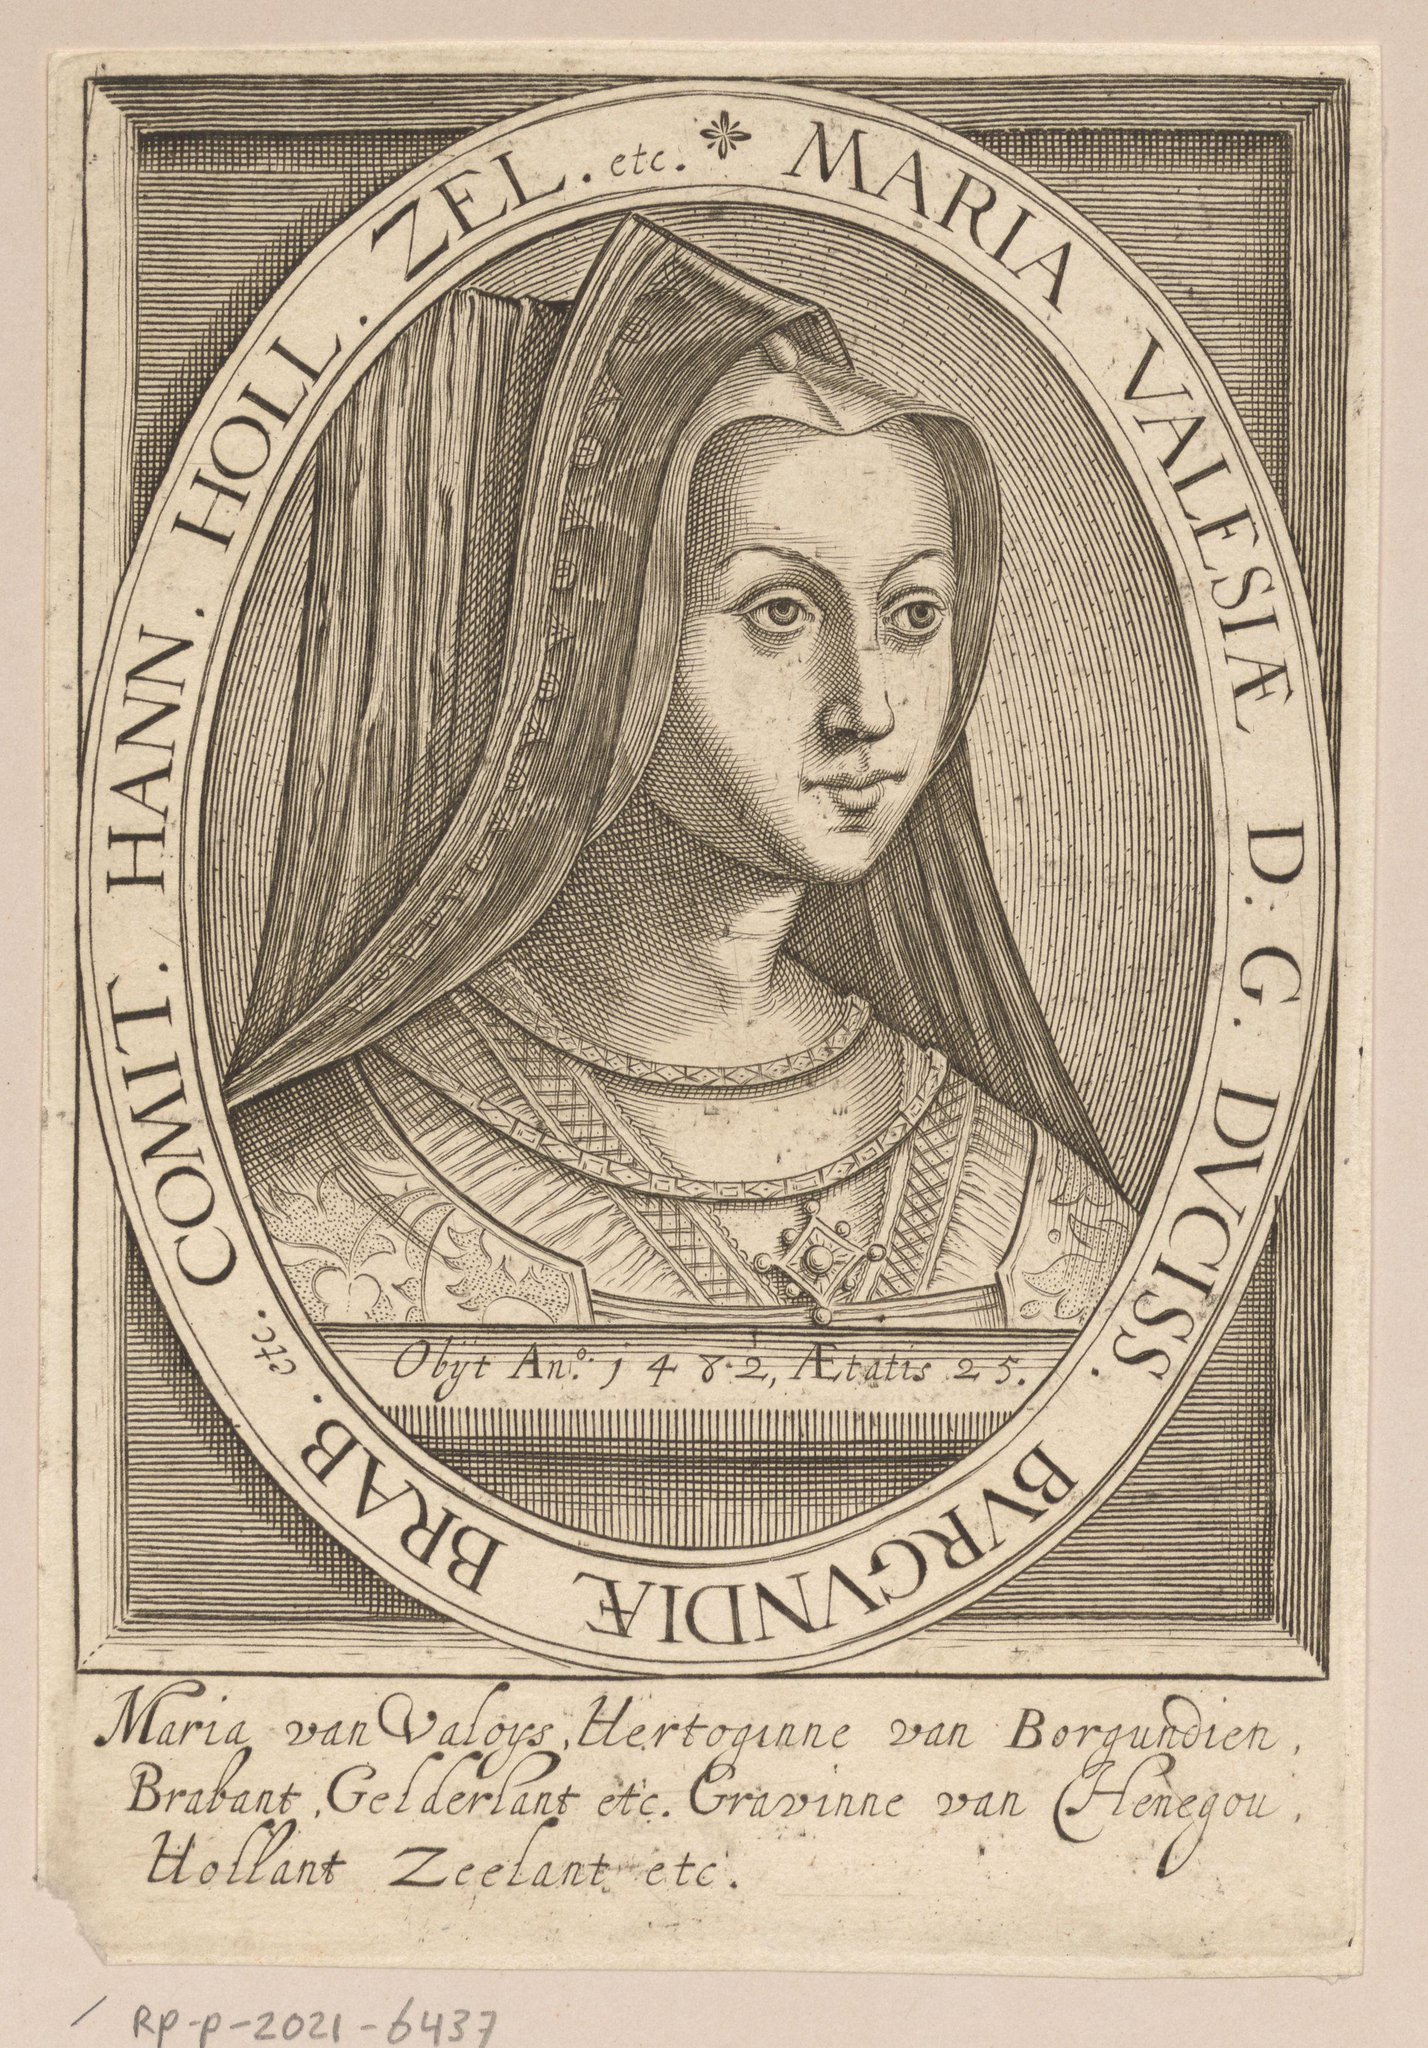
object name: print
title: Portret van Maria van Bourgondië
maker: Anonymous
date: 1614-1617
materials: paper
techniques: engraving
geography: northern netherlands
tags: brussels, bruges, maria (hertogin van bourgondië), historical persons - bb - woman, ornament ~ medallion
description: Prent met tekst in boekdruk op verso gebruikt in: Meteren, Emanuel van. Historie der Neder-landscher ende haerder na-buren oorlogen (...). Den Haag: Hillebrant Jacobsz van Wouw, 1614. En ook in: Tooneel der beroemder hertogen princen graven ende krygs-helden van christenrijck binnen deze drij laetste eeuwen. Delft: Nicolaes de Clerck, 1617. Mogelijk is de prent nog in andere edities en vertalingen van Van Meterens 'Nederlandsche Historien' gebruikt.